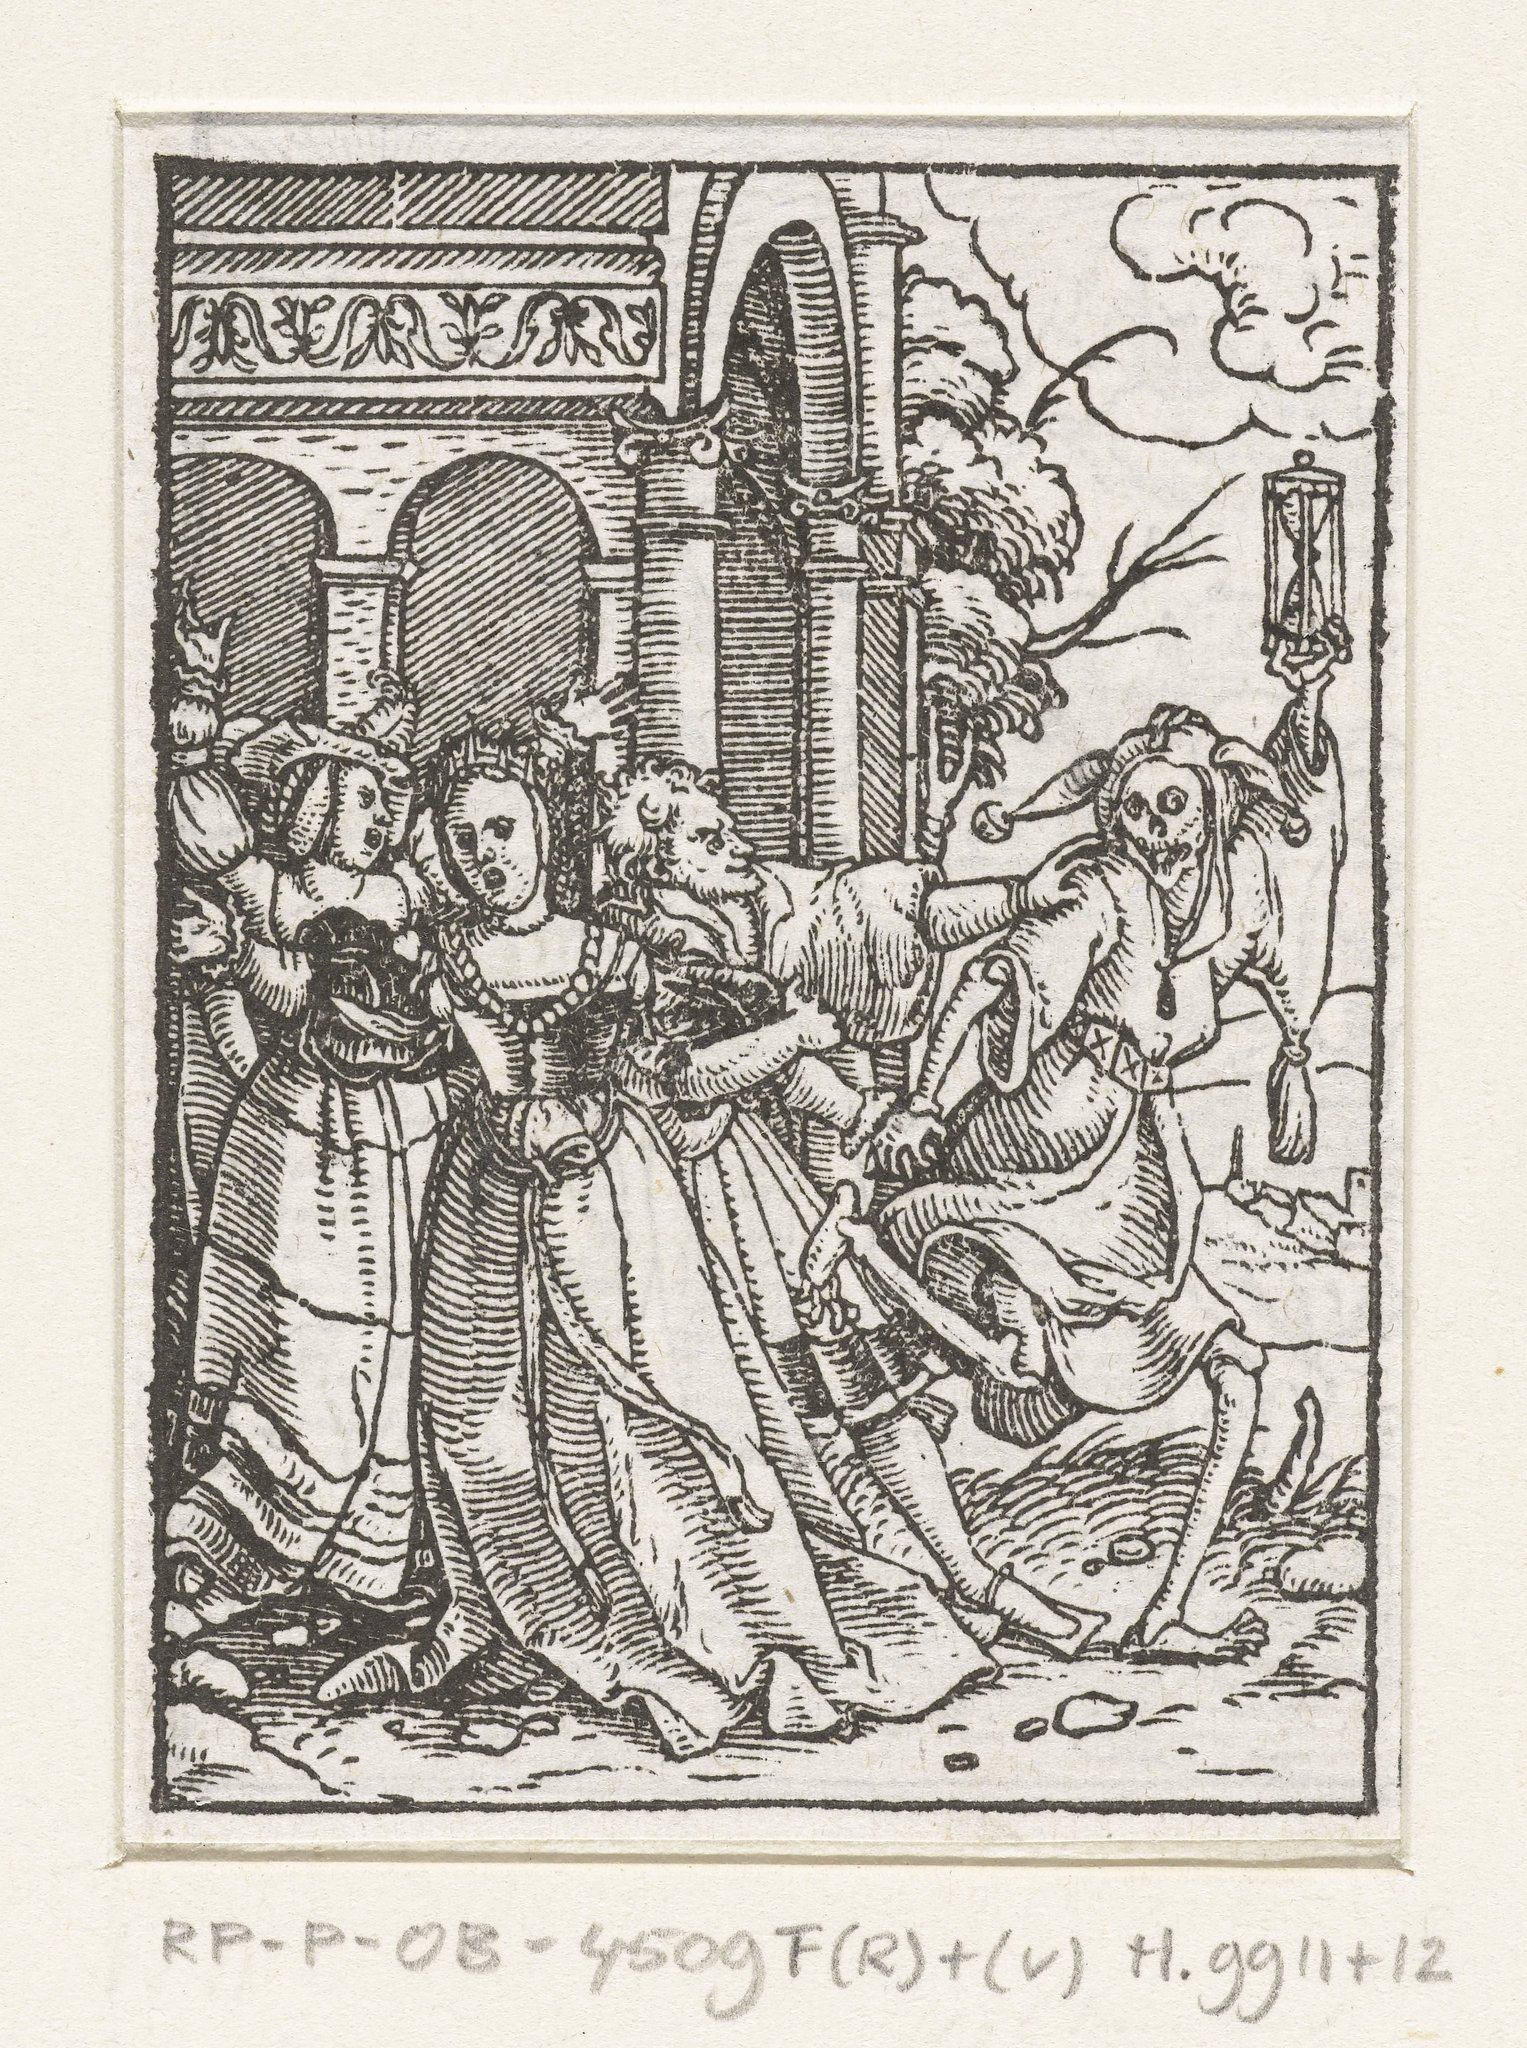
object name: book illustration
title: Koningin en de Dood als nar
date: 1524-1526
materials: paper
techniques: woodcut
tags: queen, empress, etc. (wife of a ruler), dance of death; death together with one or more human beings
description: De houtblokken werden voor 1526 vervaardigd door Hans Lützelburg en pas in 1538 voor het eerst gebruikt als boekillustraties in: Les simulachres & historiees faces de la mort avtant elegamment pourtraictes que artificiellement imaginées... a Lyon, Soubsz l'escu de Coloigne, MDXXXVIII, (M. en G. Trechsel, voor F. Frellon in Lyon), 1538. Later verschenen nog andere uitgaven.